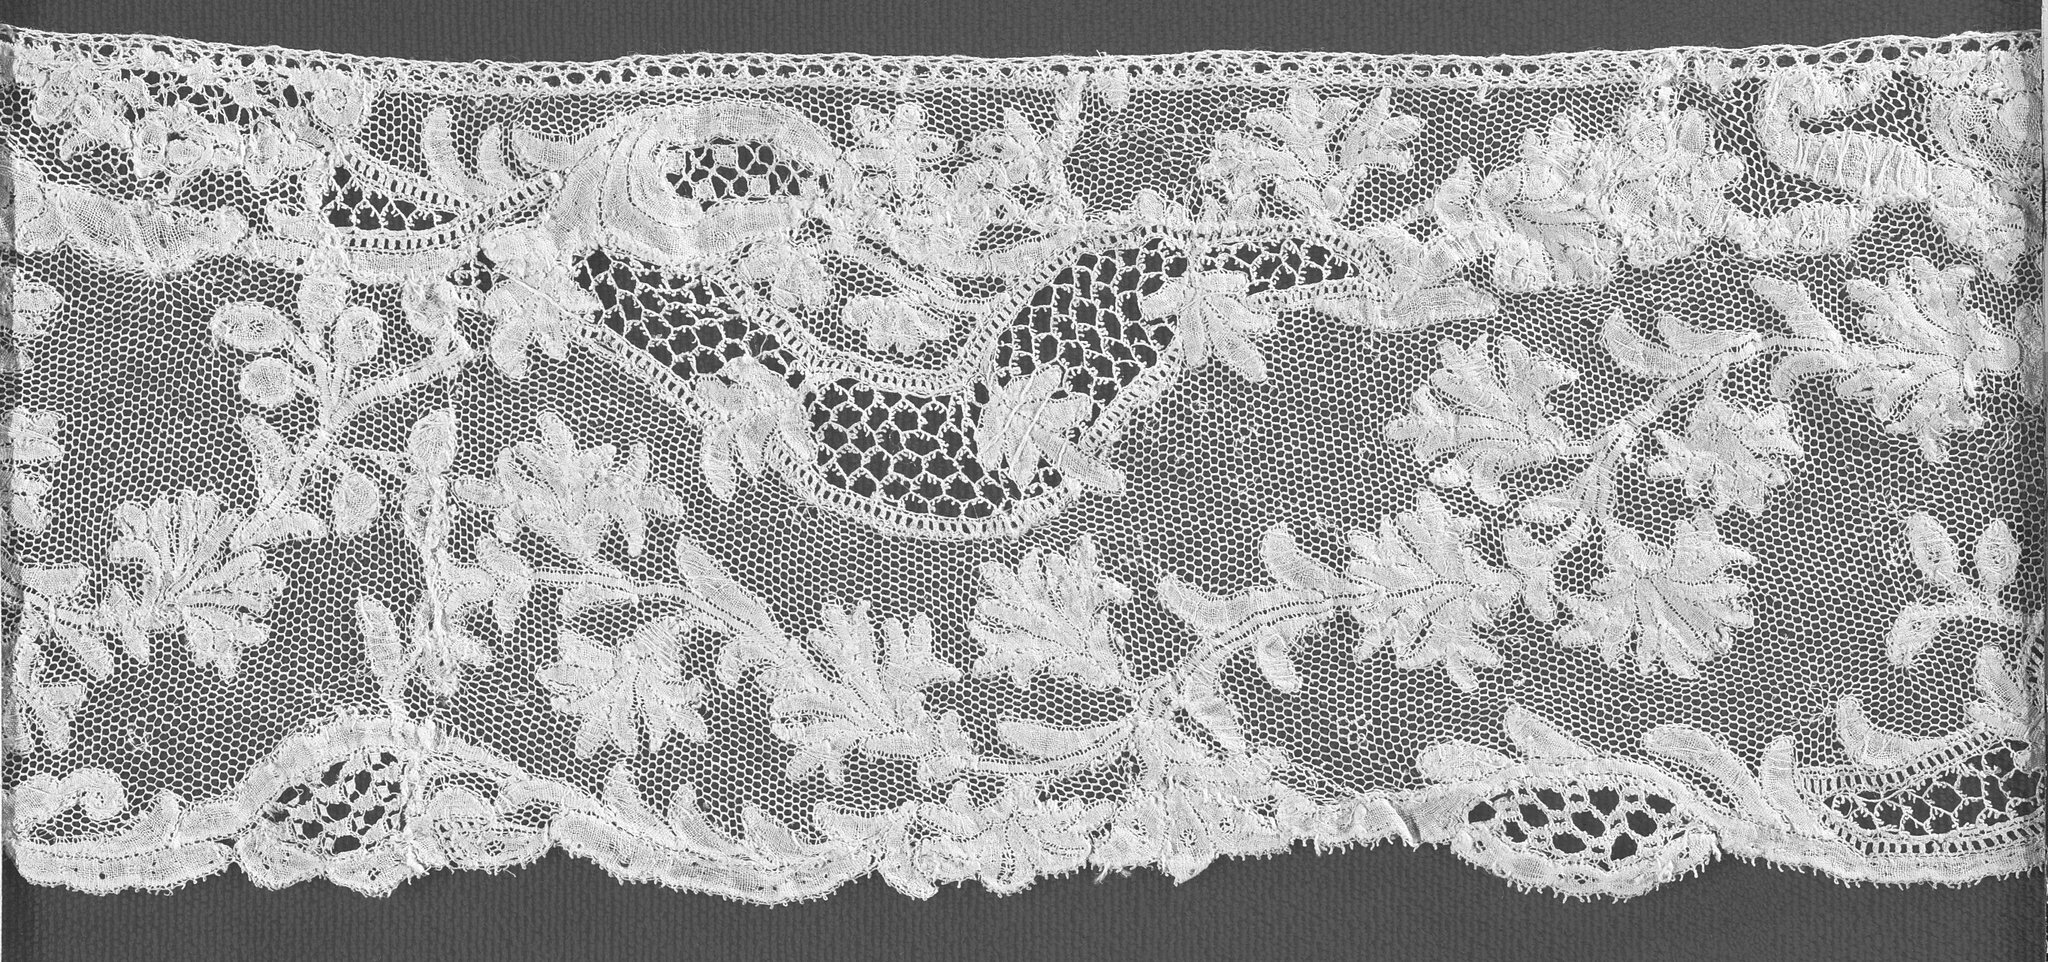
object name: strip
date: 1701-1800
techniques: lace